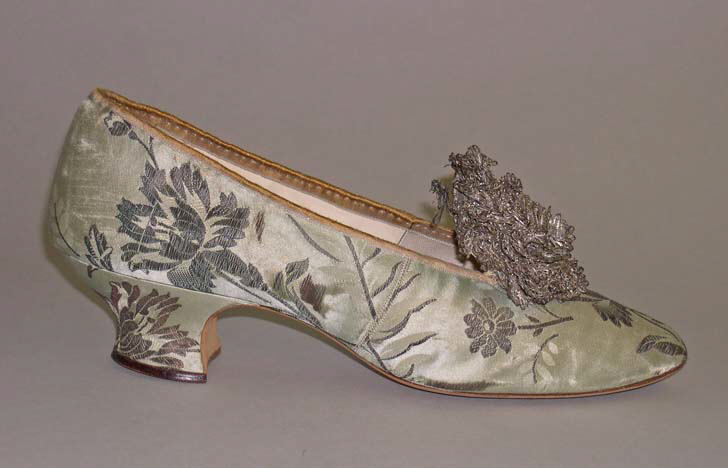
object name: slipper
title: Slippers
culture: american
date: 1891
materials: metal thread, silk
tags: flowers